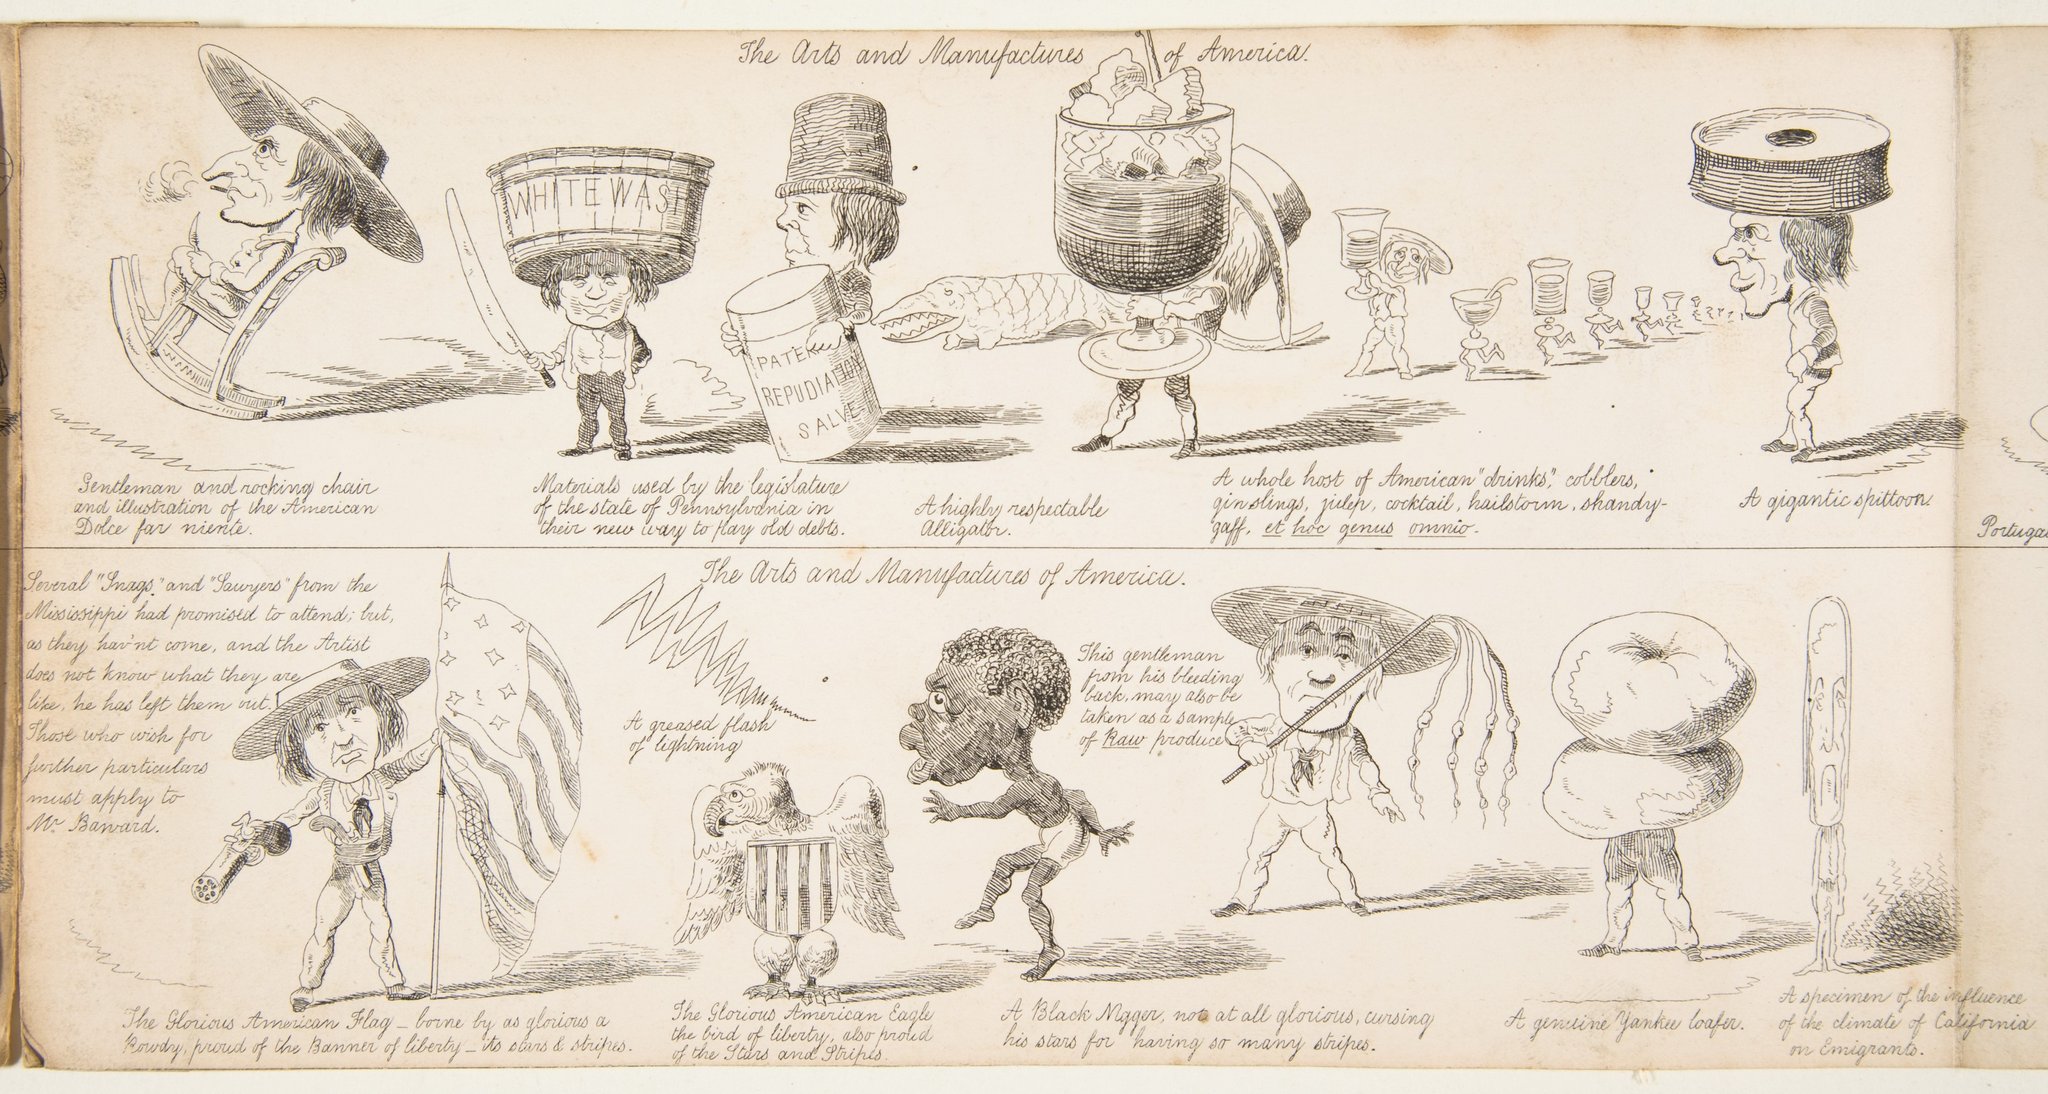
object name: print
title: The Great Exhibition "Wot is to Be", Probable Results of The Industry of All Nations in The Year '51, Showing What is to be Exhibited, Who is To Exhibit, in Short How Its All Going to Be Done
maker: george augustus sala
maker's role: author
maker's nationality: british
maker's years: 1828-1895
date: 1850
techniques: engraving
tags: satire,men,coat of arms,flags